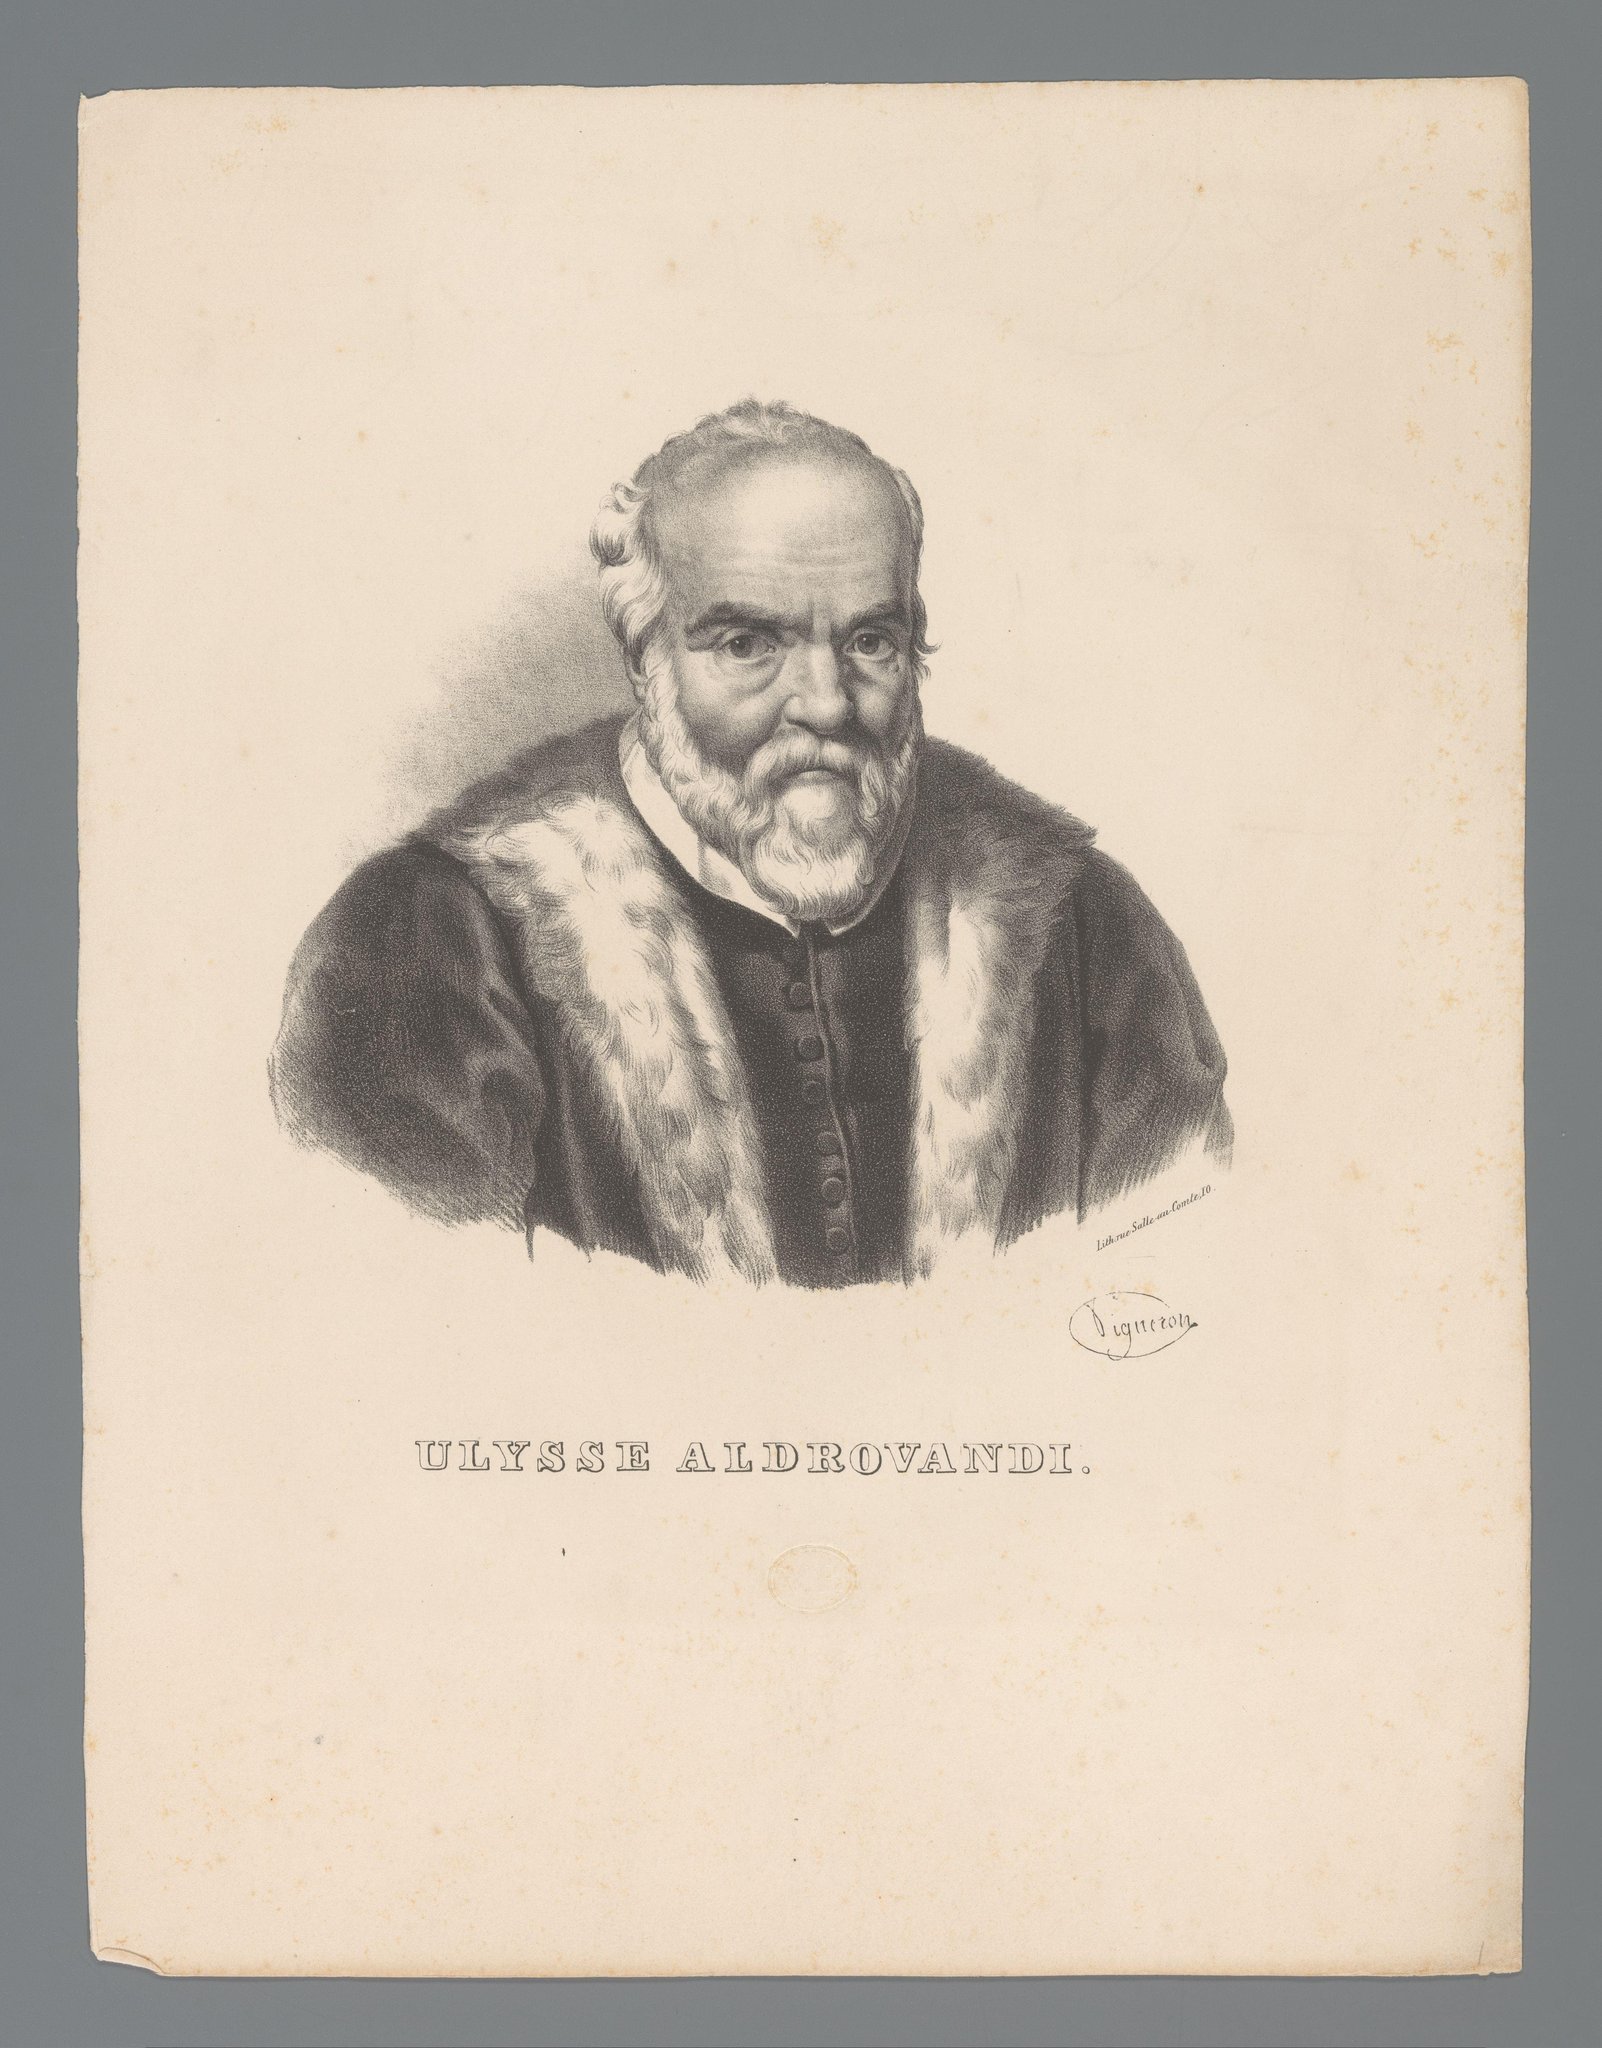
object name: print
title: Ulysse Aldrovandi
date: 1830-1853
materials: paper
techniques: lithograph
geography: paris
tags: historical persons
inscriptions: collector's mark: Lugt 2228, check stamp: Lugt 3693